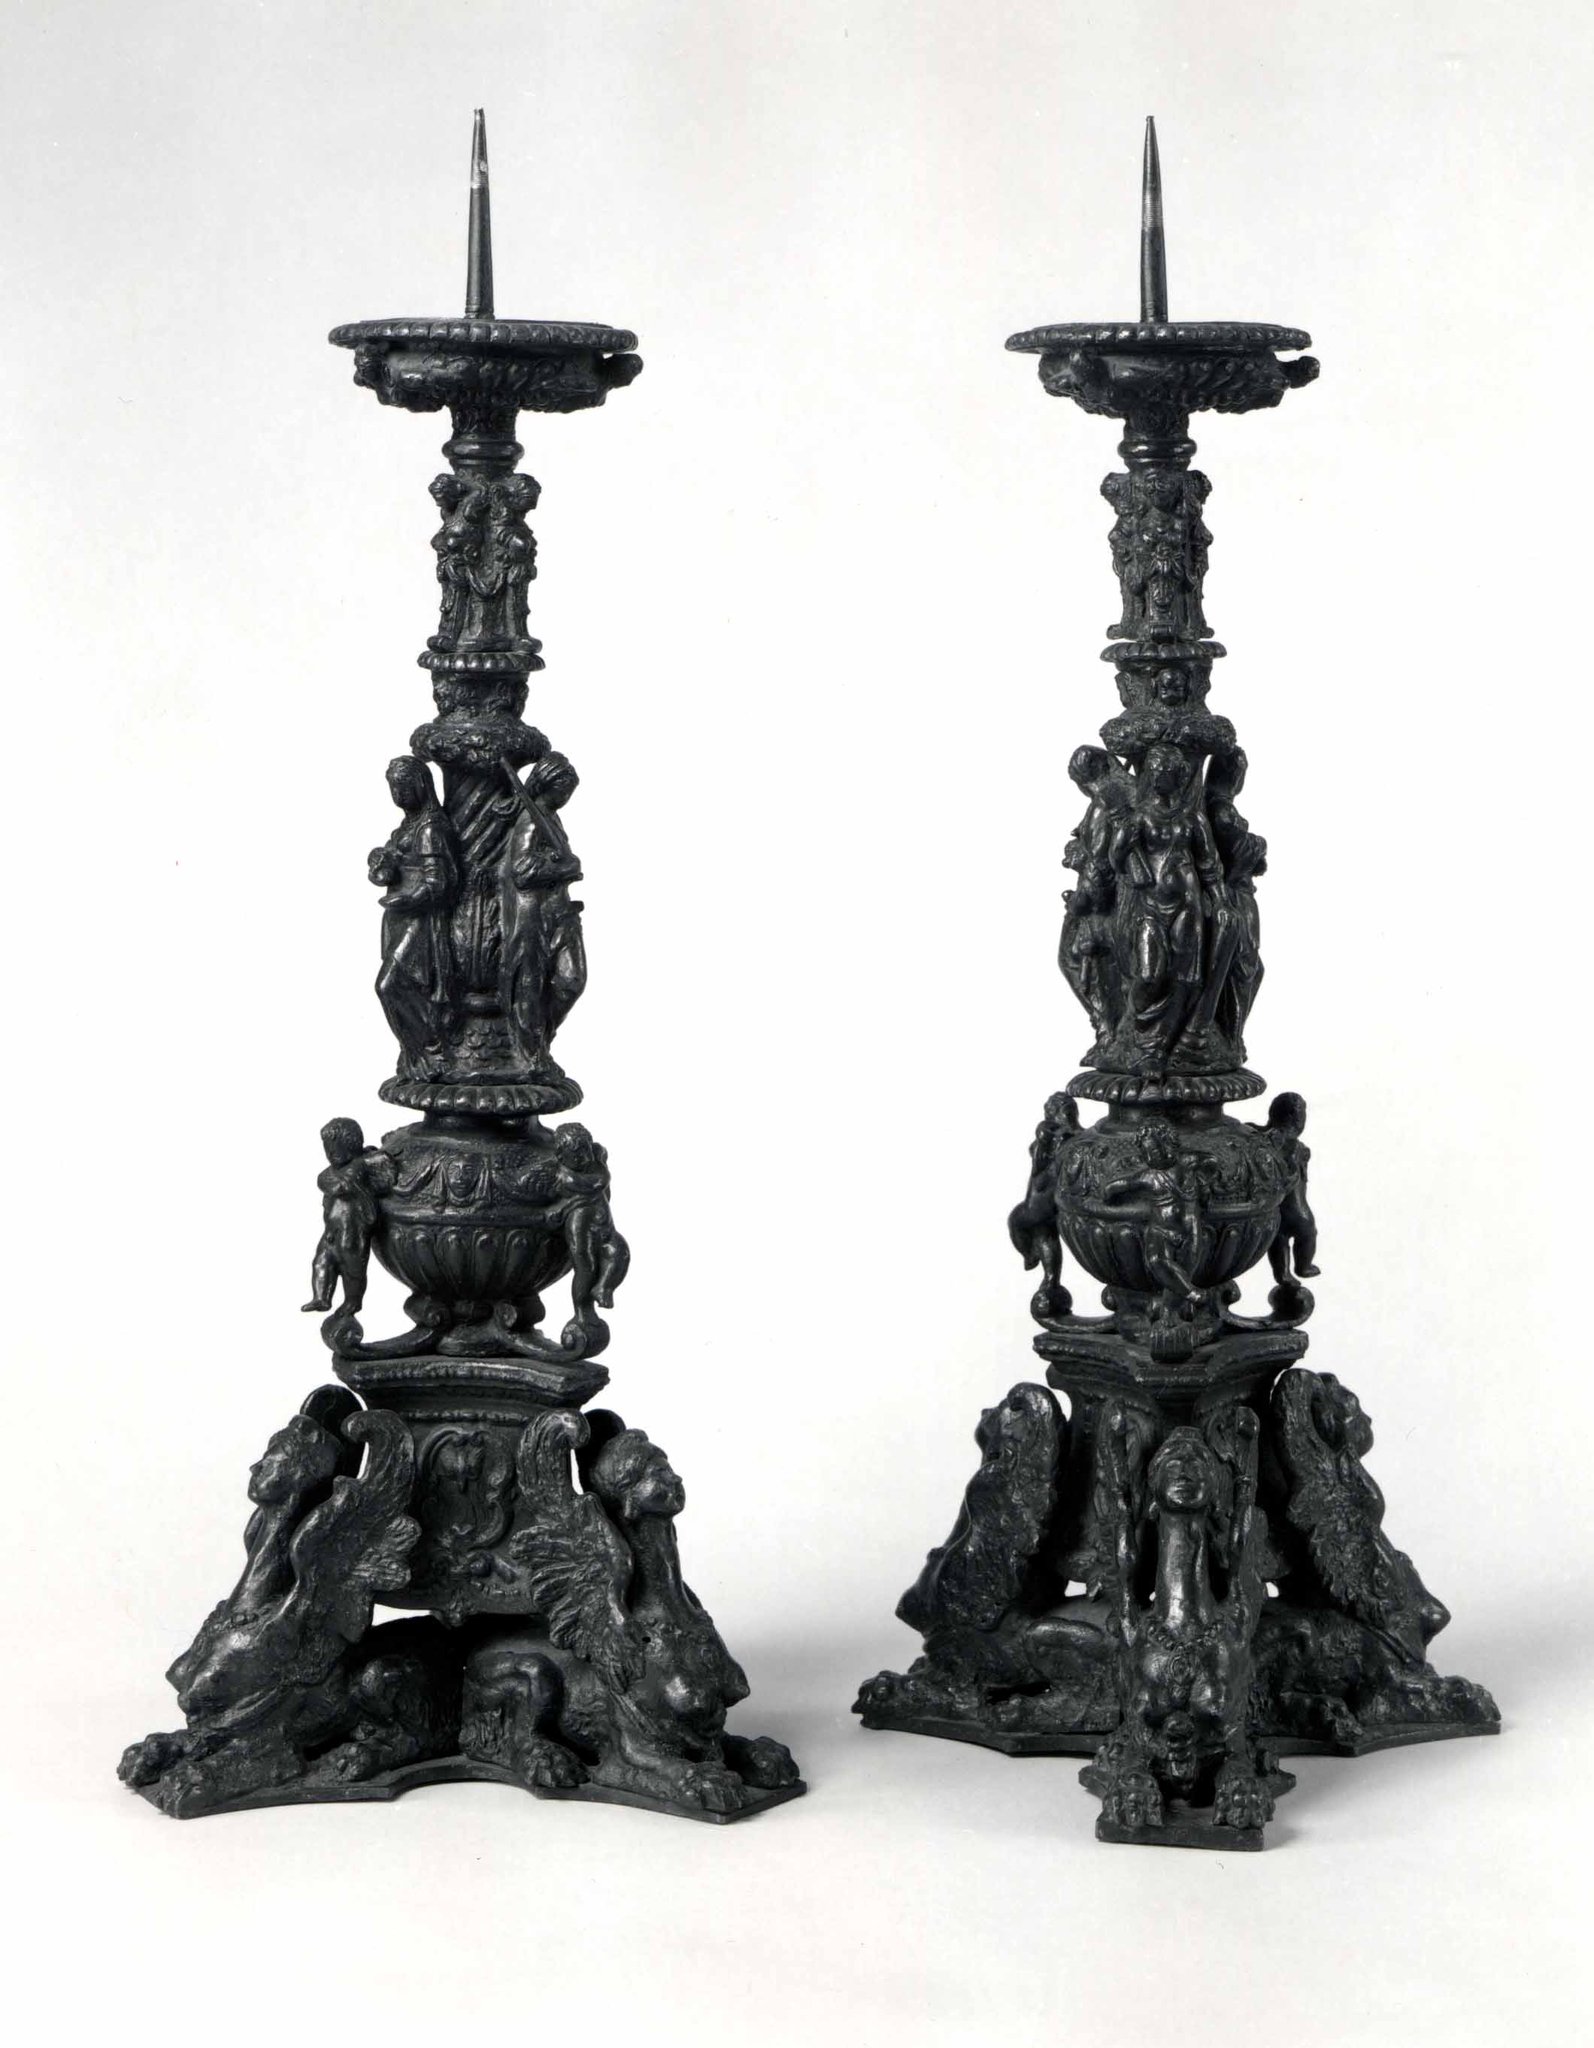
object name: candlestick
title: Altar candlestick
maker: andrea di alessandri, called il bresciano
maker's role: artist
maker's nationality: italian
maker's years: 1530-1569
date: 1565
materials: copper alloy, patina, varnish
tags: women,sphinx,putti